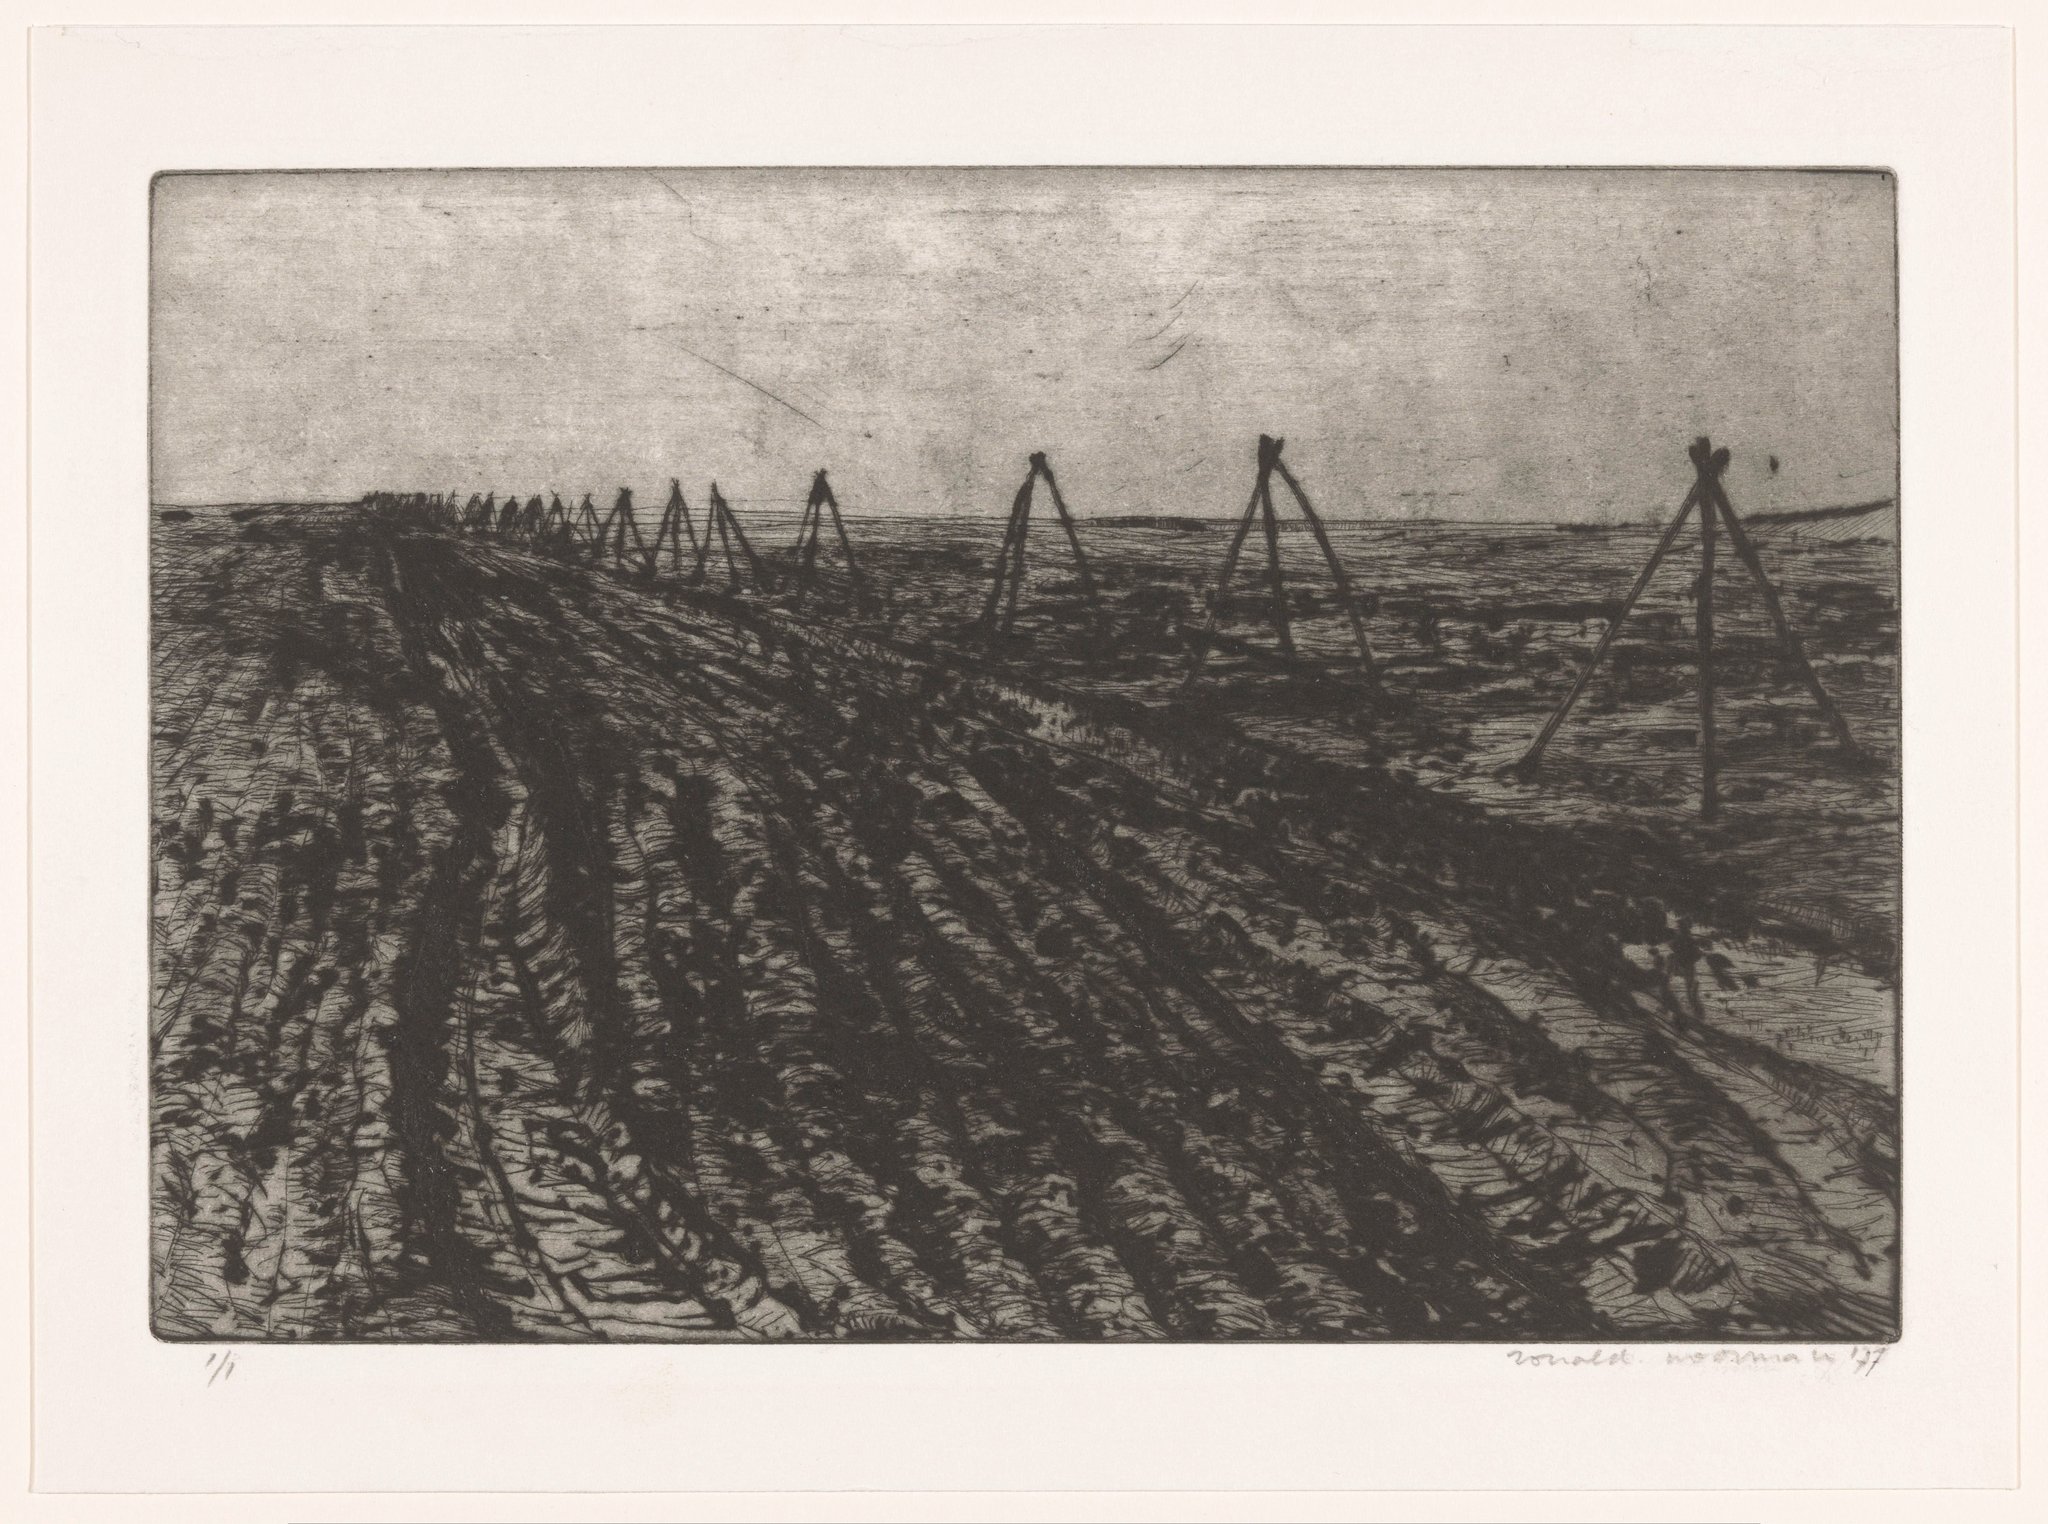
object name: print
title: Omgeploegd veld met ruiters in het Meetjeslands krekengebied, België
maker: ronald noorman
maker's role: draughtsman, print maker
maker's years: 1951-2018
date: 1977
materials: paper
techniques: drypoint, intaglio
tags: ploughed field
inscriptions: collector's mark: Lugt 2228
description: Omgeploegd veld ergens in het Meetjeslands krekengebied met daarop zogenaamde ruiters. Deze worden gebruikt om er het vlas of het bonenloof op te drogen.